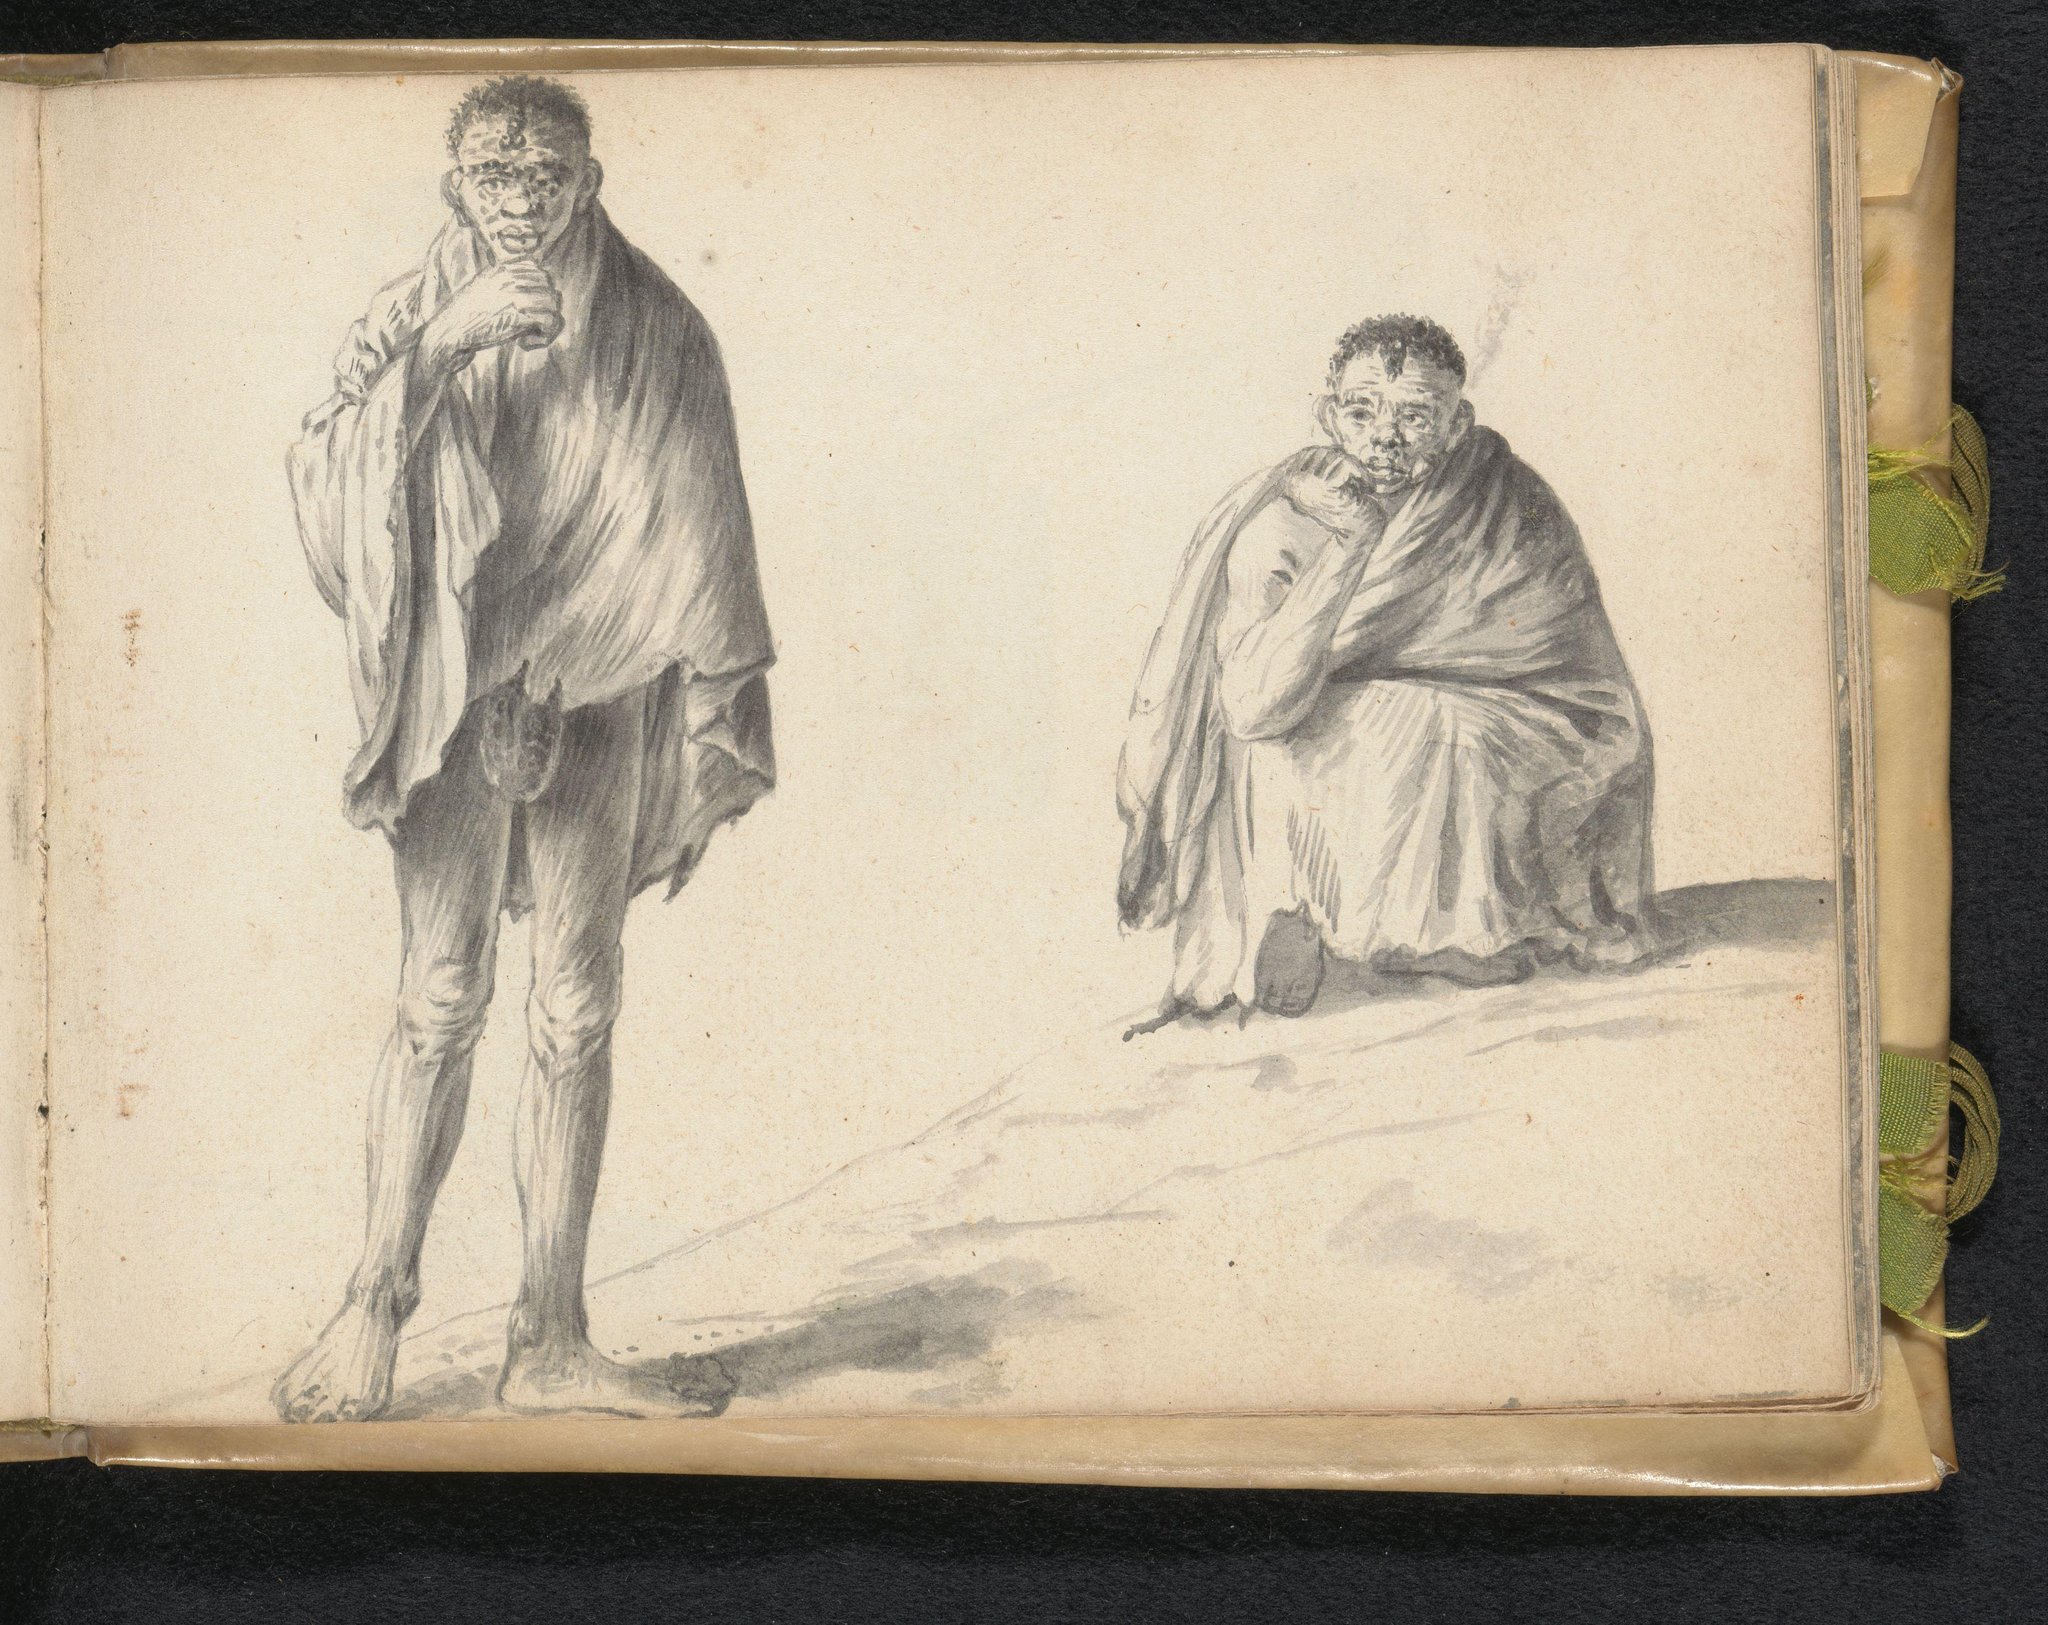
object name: sketchbook leaf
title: Two South African Khoisan men; one smokes a pipe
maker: esaias boursse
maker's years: 1631-1672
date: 1662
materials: ink, paper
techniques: brush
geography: cape of good hope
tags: (person with) albinism, african peoples (khoisan), pipe ~ tobacco, cape of good hope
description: De tekenaar heeft vlekken getekend op het gezicht van de linker man, wellicht heeft hij albinisme. De man draagt een kleine lendendoek, en een wijde lap om zijn schouders en bovenlijf die tot over zijn heupen rijkt. Mogelijk is het een doek van textiel met gerafelde randen, dan wel de traditionele leren omslagmantel van de Khoisan. Onder de mantel is zijn kruisbedekking zichtbaar. De man rechts zit gehurkt op de helling. Op rechterschouder en arm na is hij geheel gehuld in een wijde mantel (textiel of dierenhuid) tot over zijn knieën. Zijn beide voeten zijn nog zichtbaar. Tussen zijn lippen houdt hij een Goudse pijp met kort afgebroken steel. Er kringelt rook uit de pijpenkop. Blad 98 uit een schetsboek met 117 bladen.